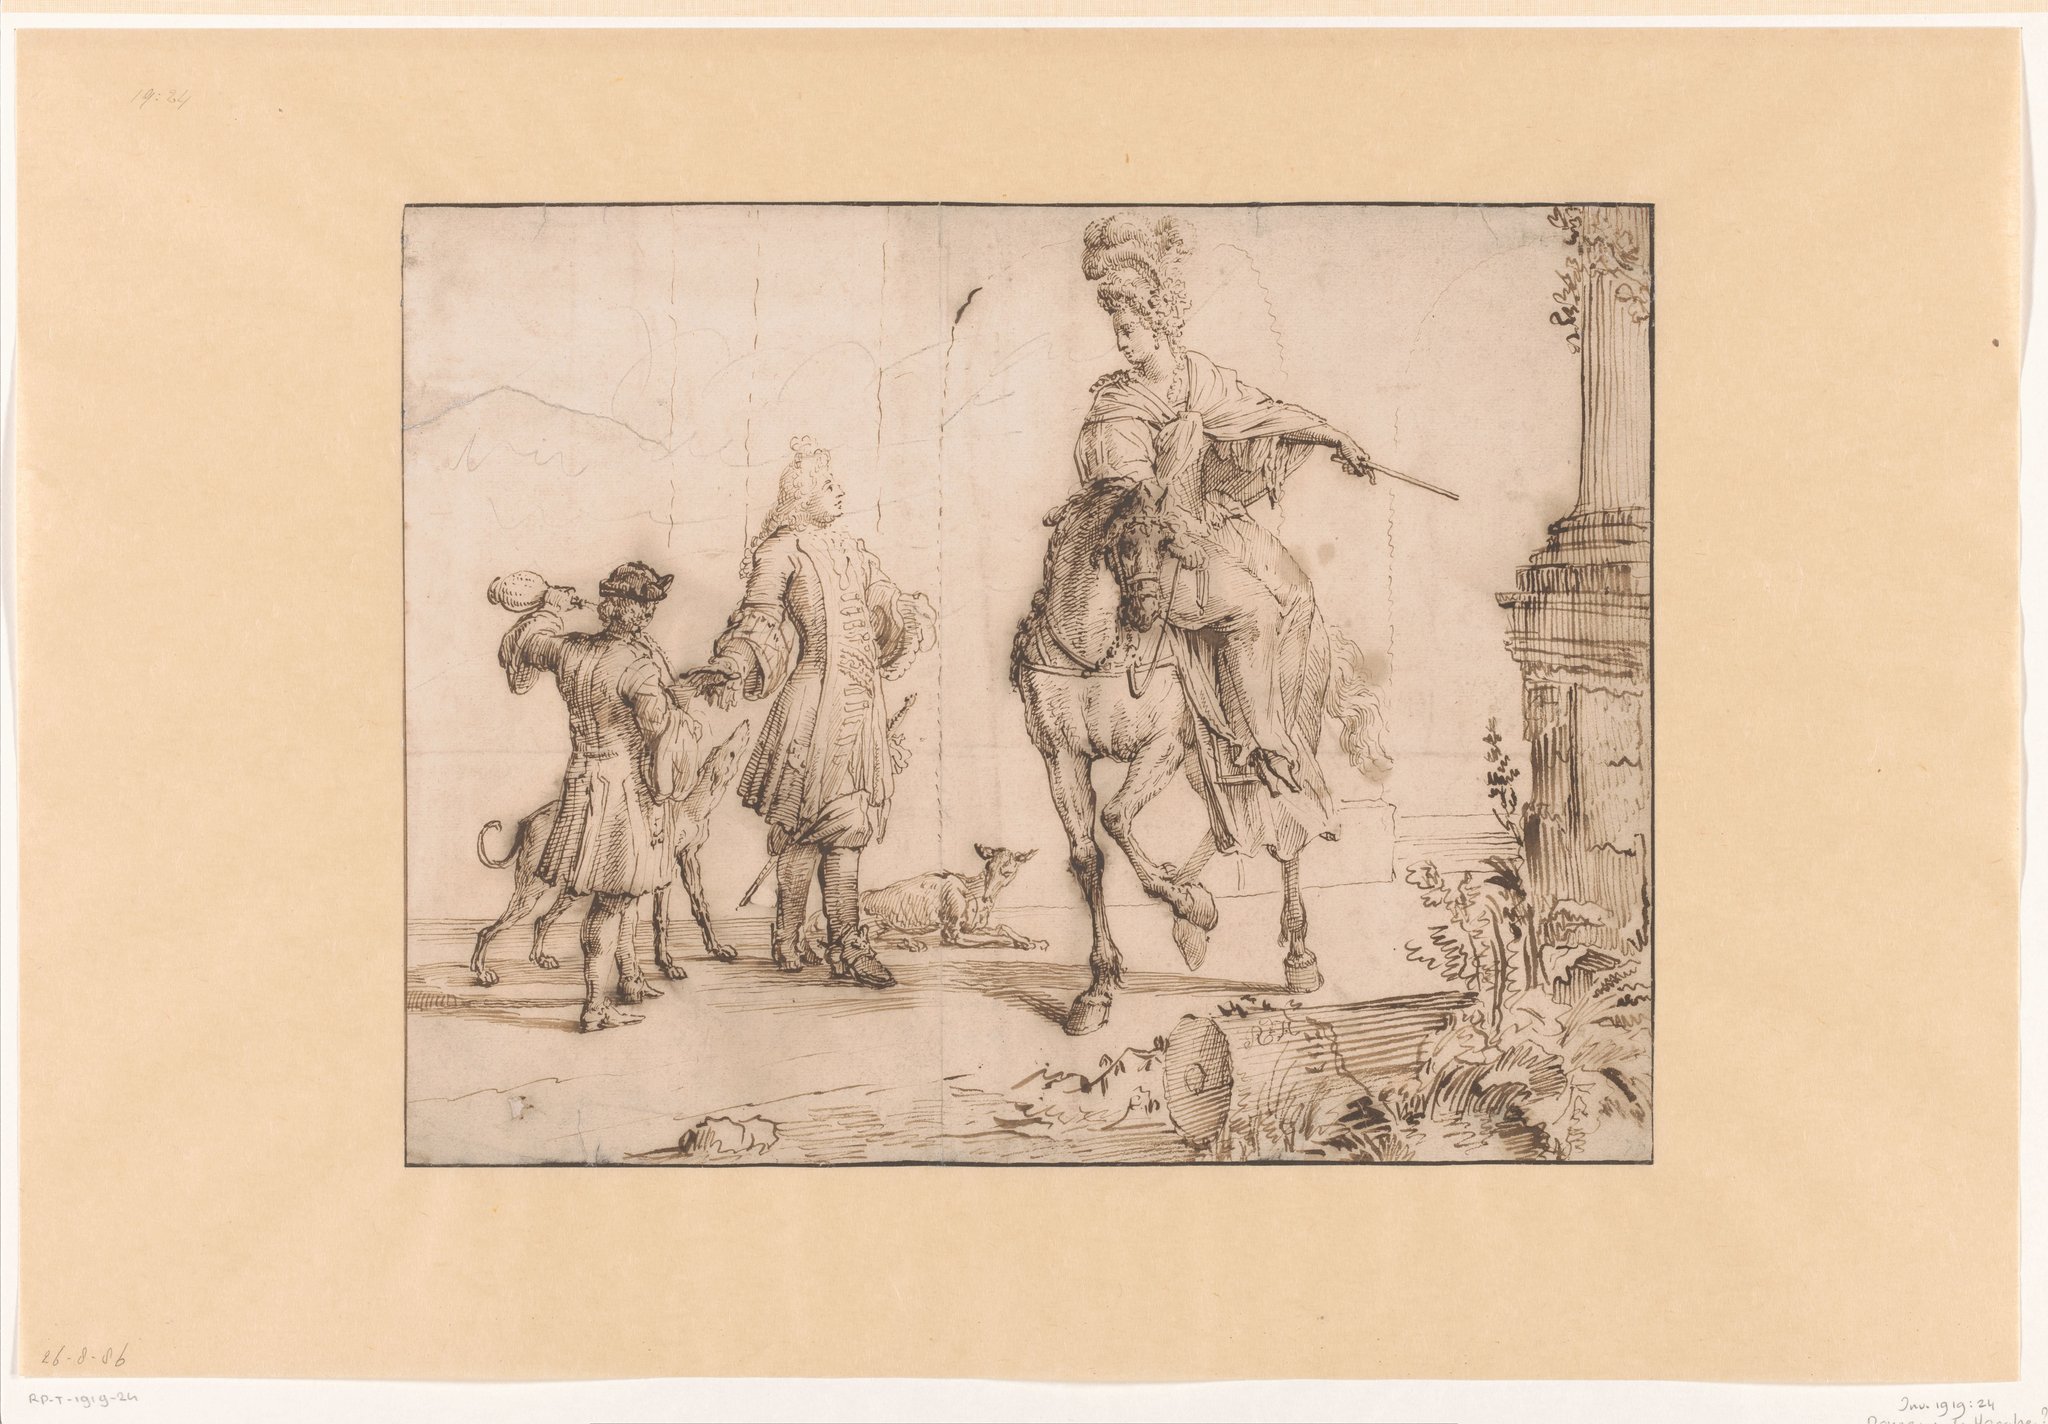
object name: drawing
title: Woman on Horseback Greeted by a Gentleman and a Servant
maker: romeyn de hooghe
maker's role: draughtsman, goldsmith, painter, print maker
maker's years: 1645-1708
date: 1688-1689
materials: ink, paper, pencil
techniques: pen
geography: haarlem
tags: pouring, male sex; man, manservant, footman, riding a horse, ass, or mule; rider, horseman (+ sitting on animal with both legs on one side, riding side-saddle)